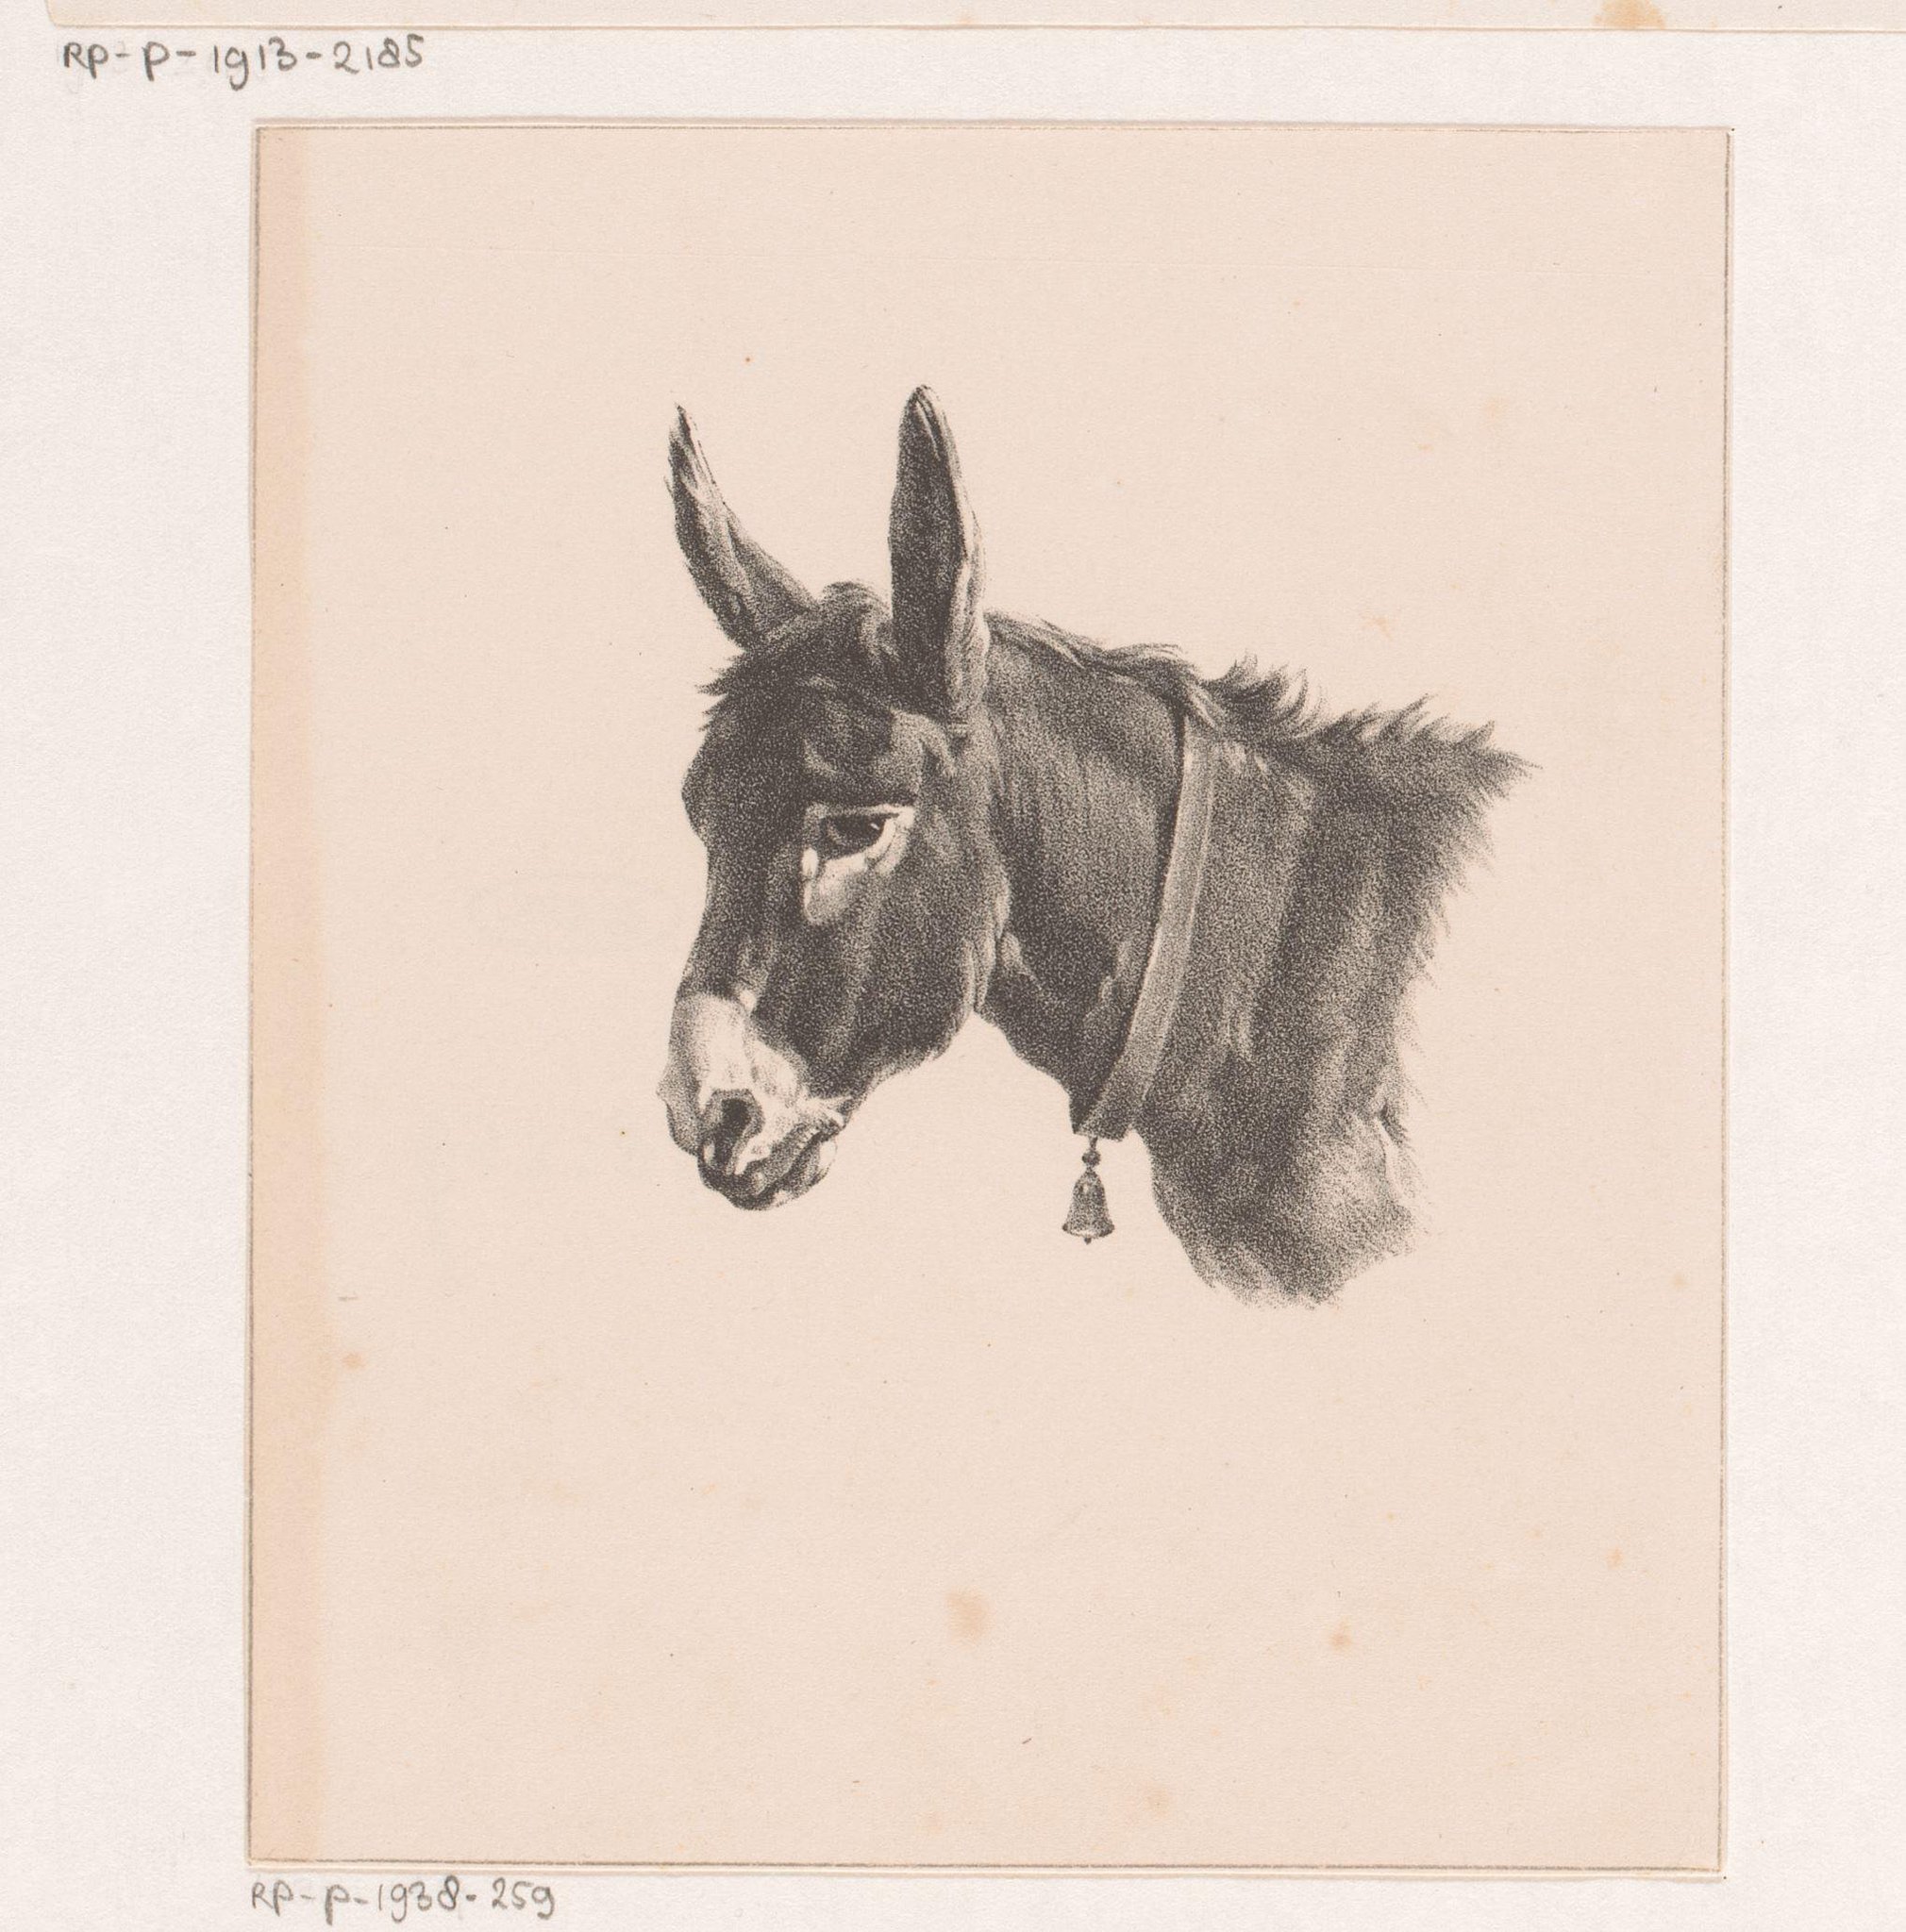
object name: print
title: Ezel met bel om zijn hals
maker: jean zacherie mazel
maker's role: draughtsman, print maker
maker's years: 1792-1884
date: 1809-1884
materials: paper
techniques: lithograph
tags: ass, donkey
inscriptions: collector's mark: Lugt 2228, collector's mark: Lugt 2760